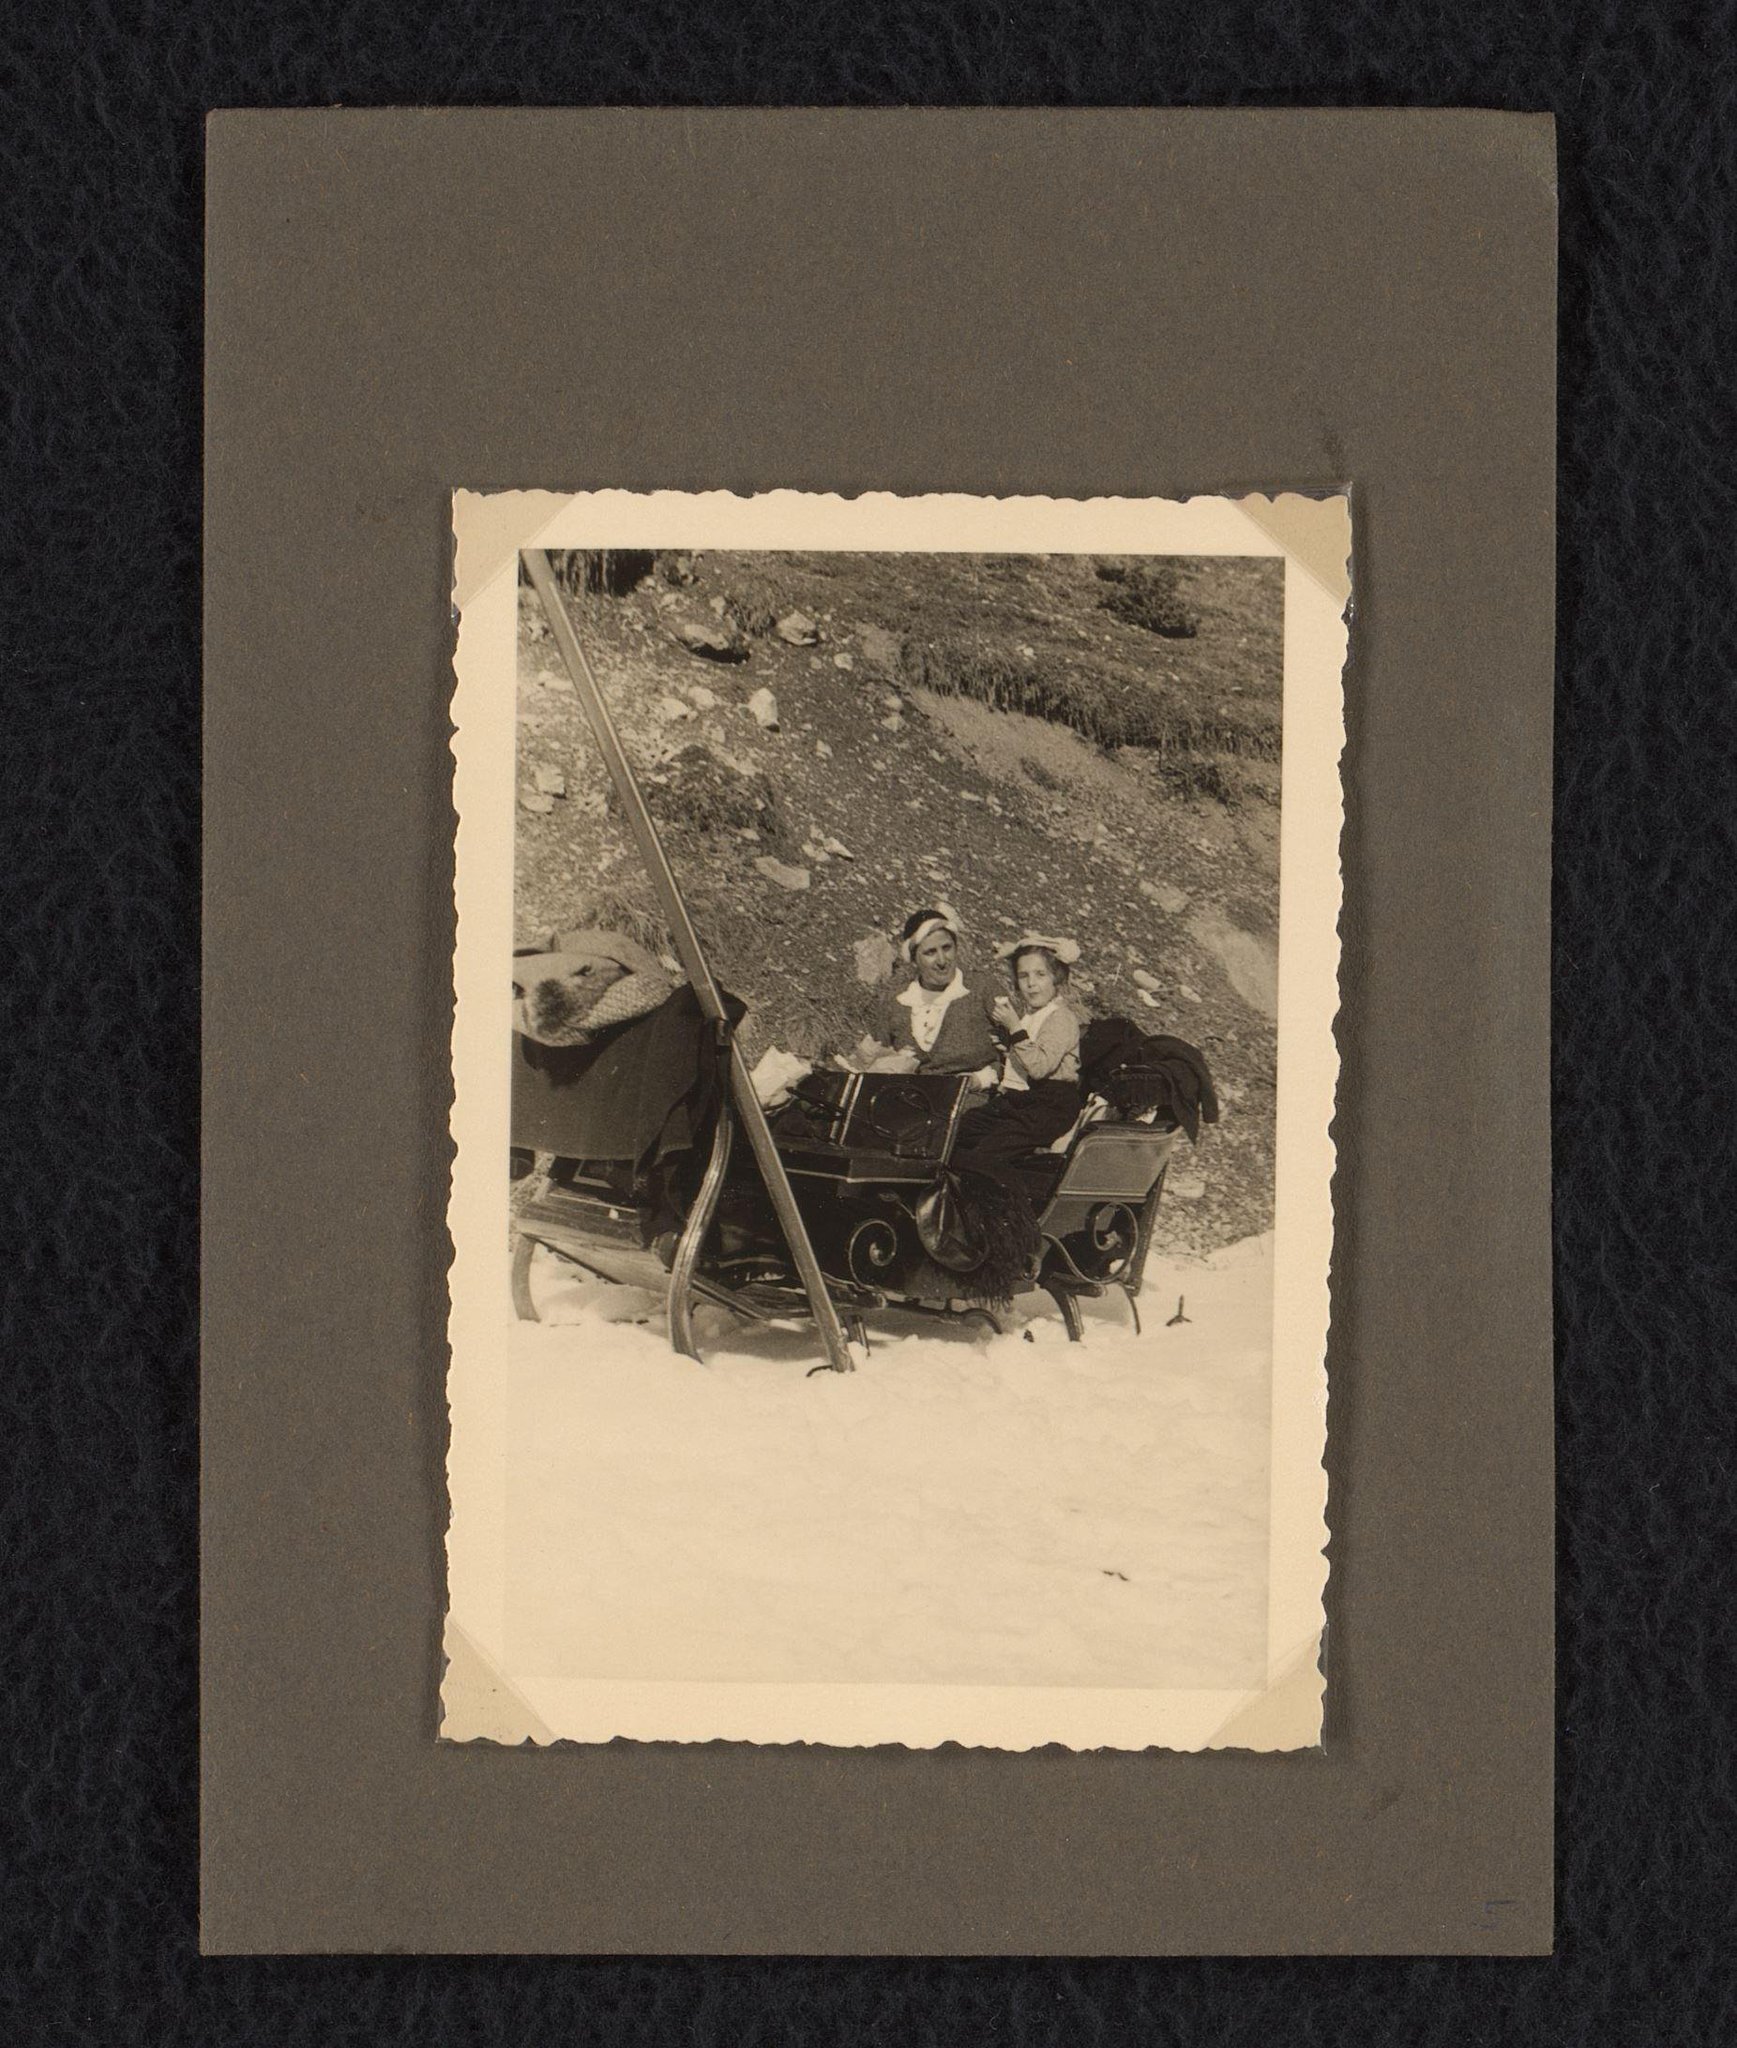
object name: photograph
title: In de slee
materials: cardboard, photographic support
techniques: gelatin silver print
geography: lenzerheide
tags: else wachenheimer-moos, isabel wachenheimer-elon, the family travelling, on holiday, sledge, sleigh (winter sports)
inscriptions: date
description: Albumblad met een foto van Isabel Wachenheimer met haar moeder Else Wachenheimer-Moos, in een arrenslee. Onderdeel van het fotoalbum met vakantiefoto's Lenzerheide, 1934.